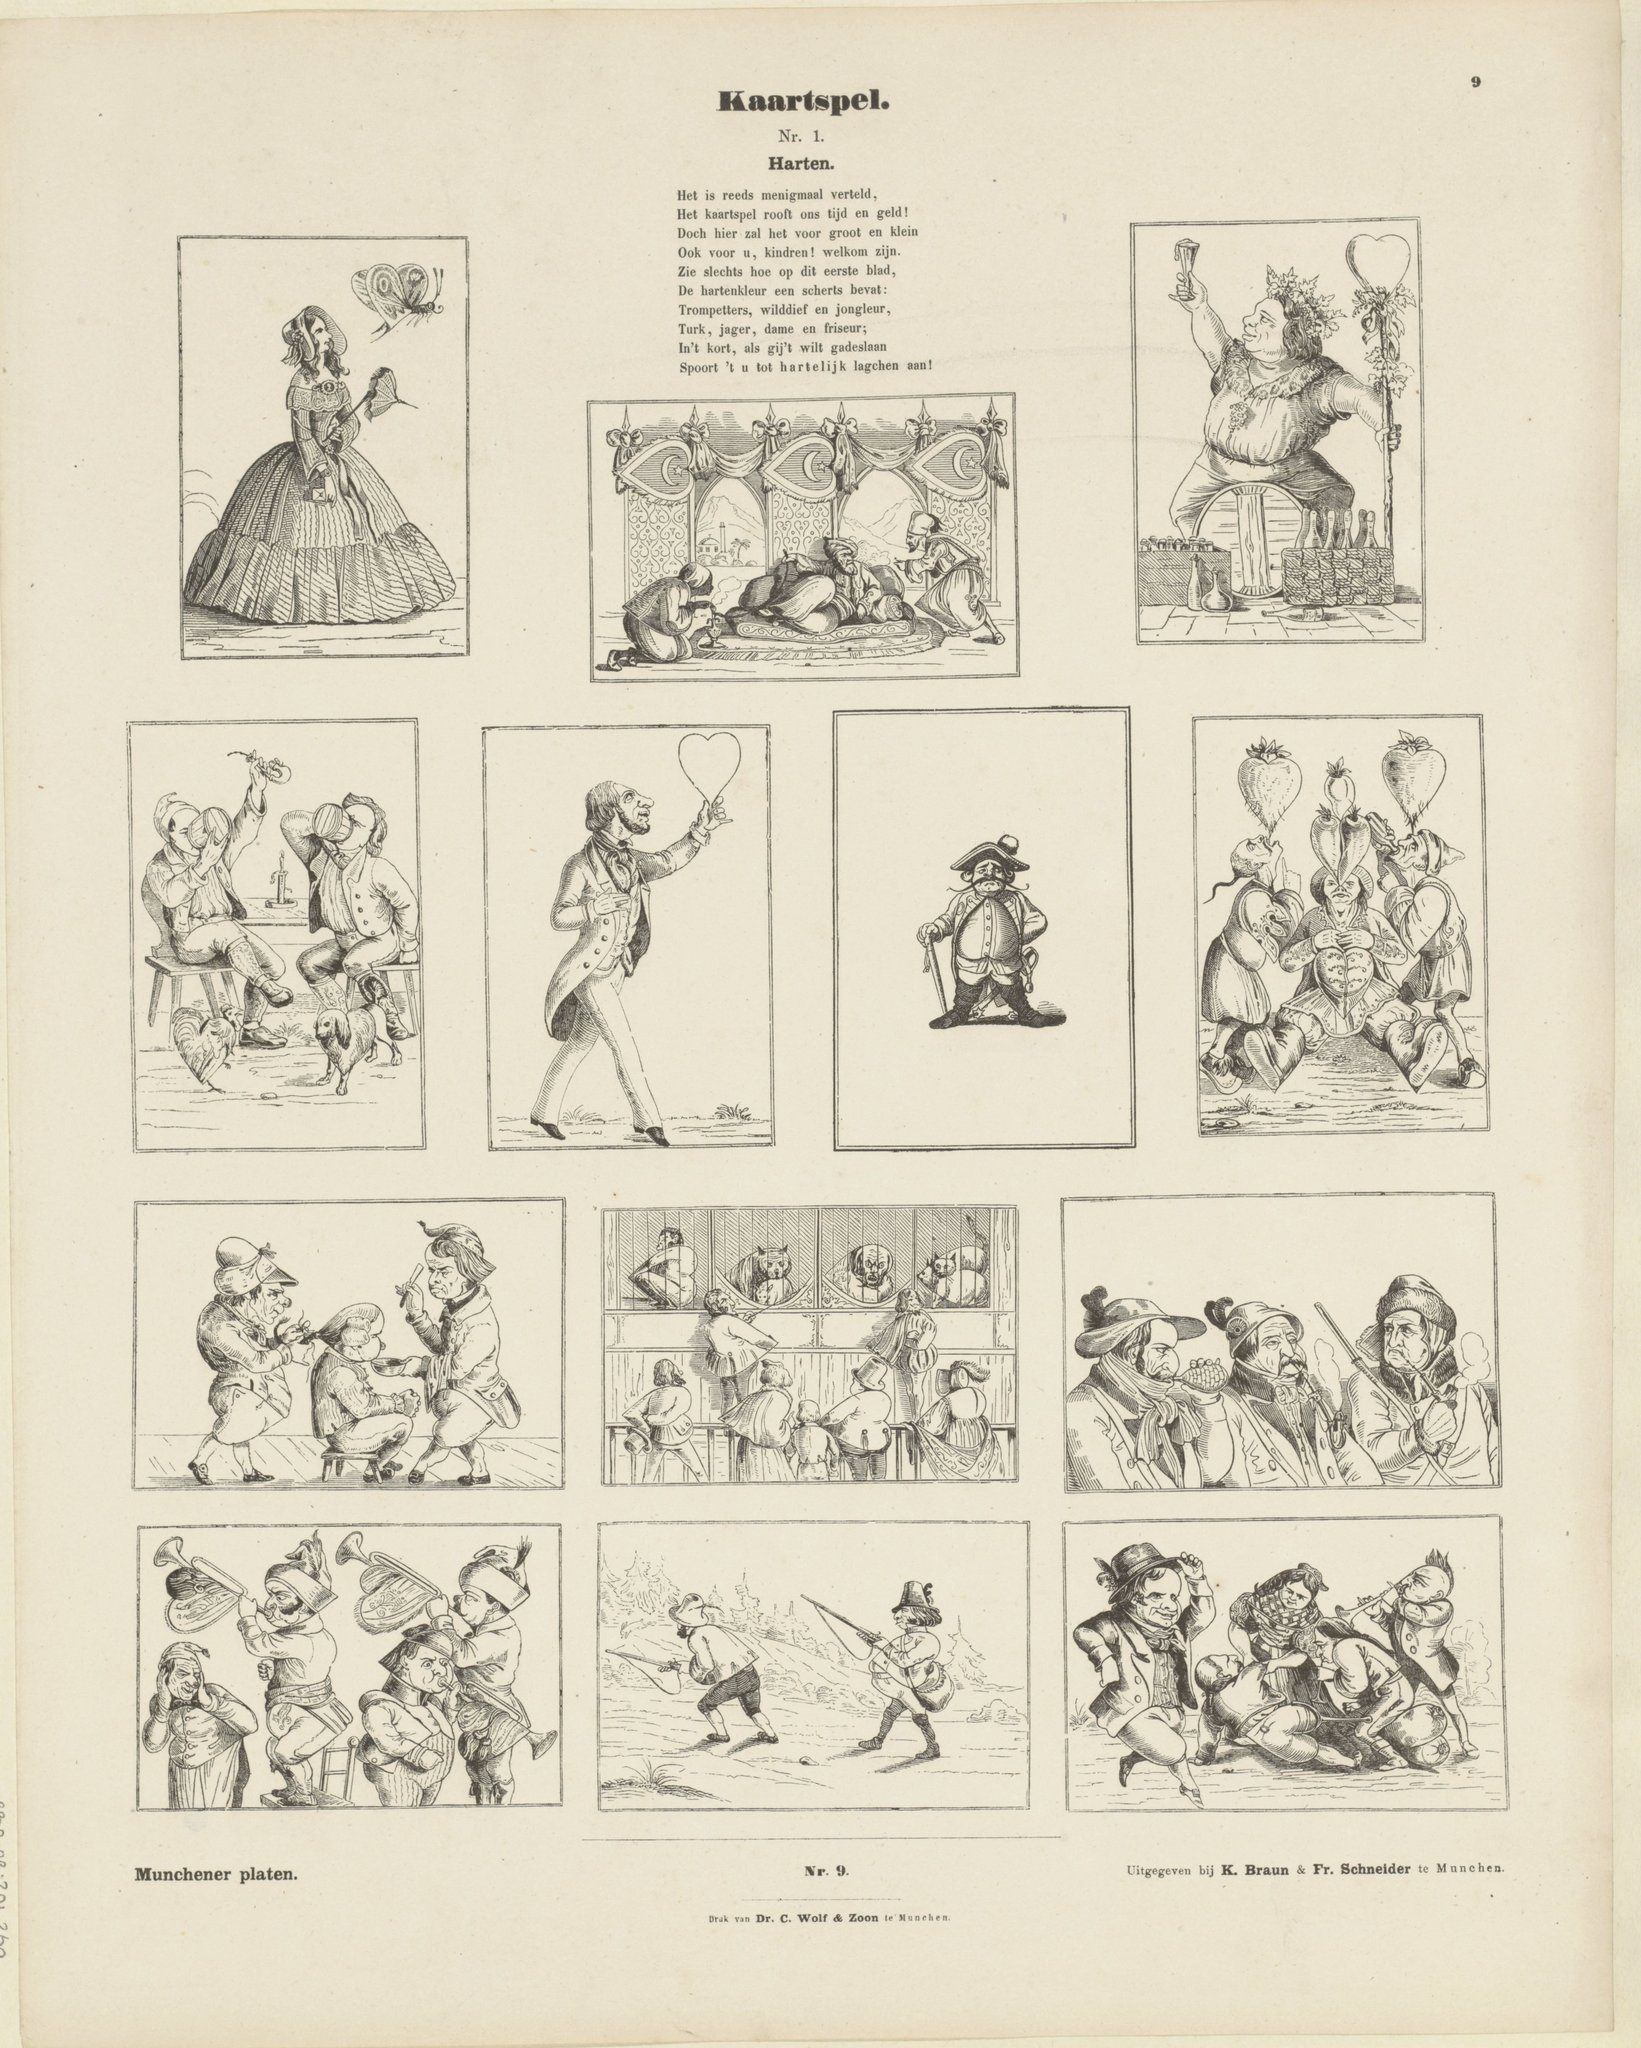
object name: popular print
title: Munchener platen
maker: j. beeg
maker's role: draughtsman, print maker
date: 1843-1920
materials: paper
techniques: letterpress printing, engraving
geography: munich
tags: playing-cards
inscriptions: collector's mark: Lugt 2760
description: Blad met 13 voorstellingen van speelkaarten (harten), met verschillende figuren. Onder de titel een tienregelig vers. Genummerd midden onder: Nr. 9. Genummerd rechtsboven: 9.